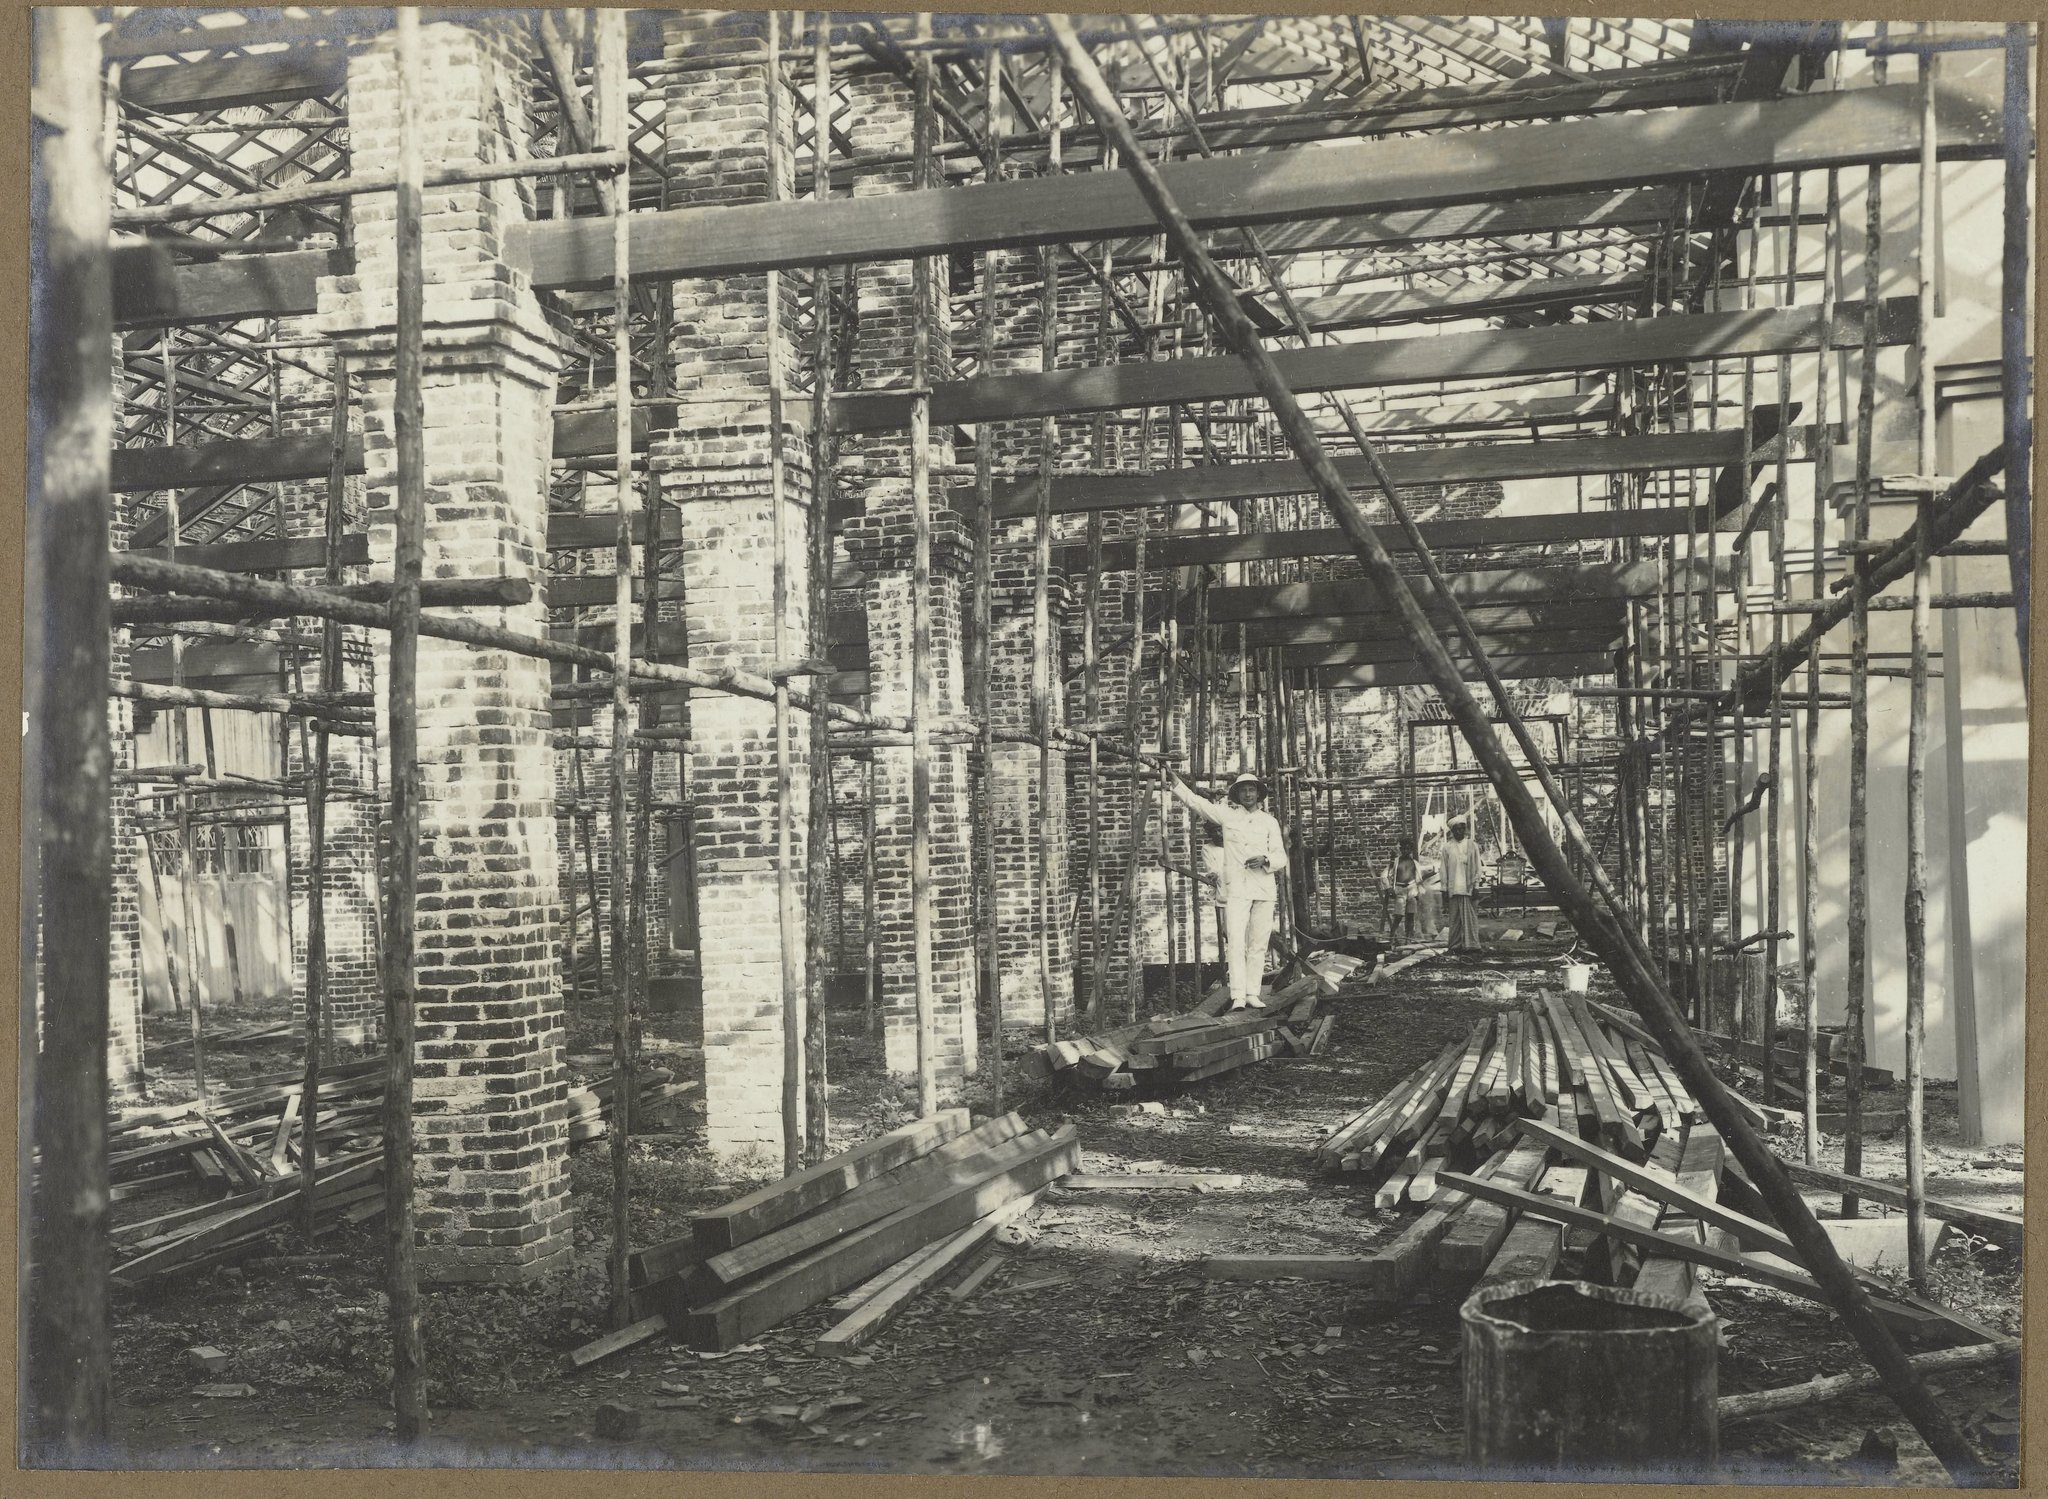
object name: photograph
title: Pand in aanbouw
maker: Anonymous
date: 1914-1919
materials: photographic support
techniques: gelatin silver print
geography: medan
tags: architect at work, making the overground structures (~ building activities), representation of real building (either existing or having existed)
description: Gezicht binnen een pand in aanbouw, een man staande tussen steigers en zuilen in een bouwskelet, waarschijnlijk te Medan. Foto in het fotoalbum van het Nederlandse architectenbureau en aannemersbedrijf Bennink en Riphagen te Medan in de jaren ca. 1914-1919.